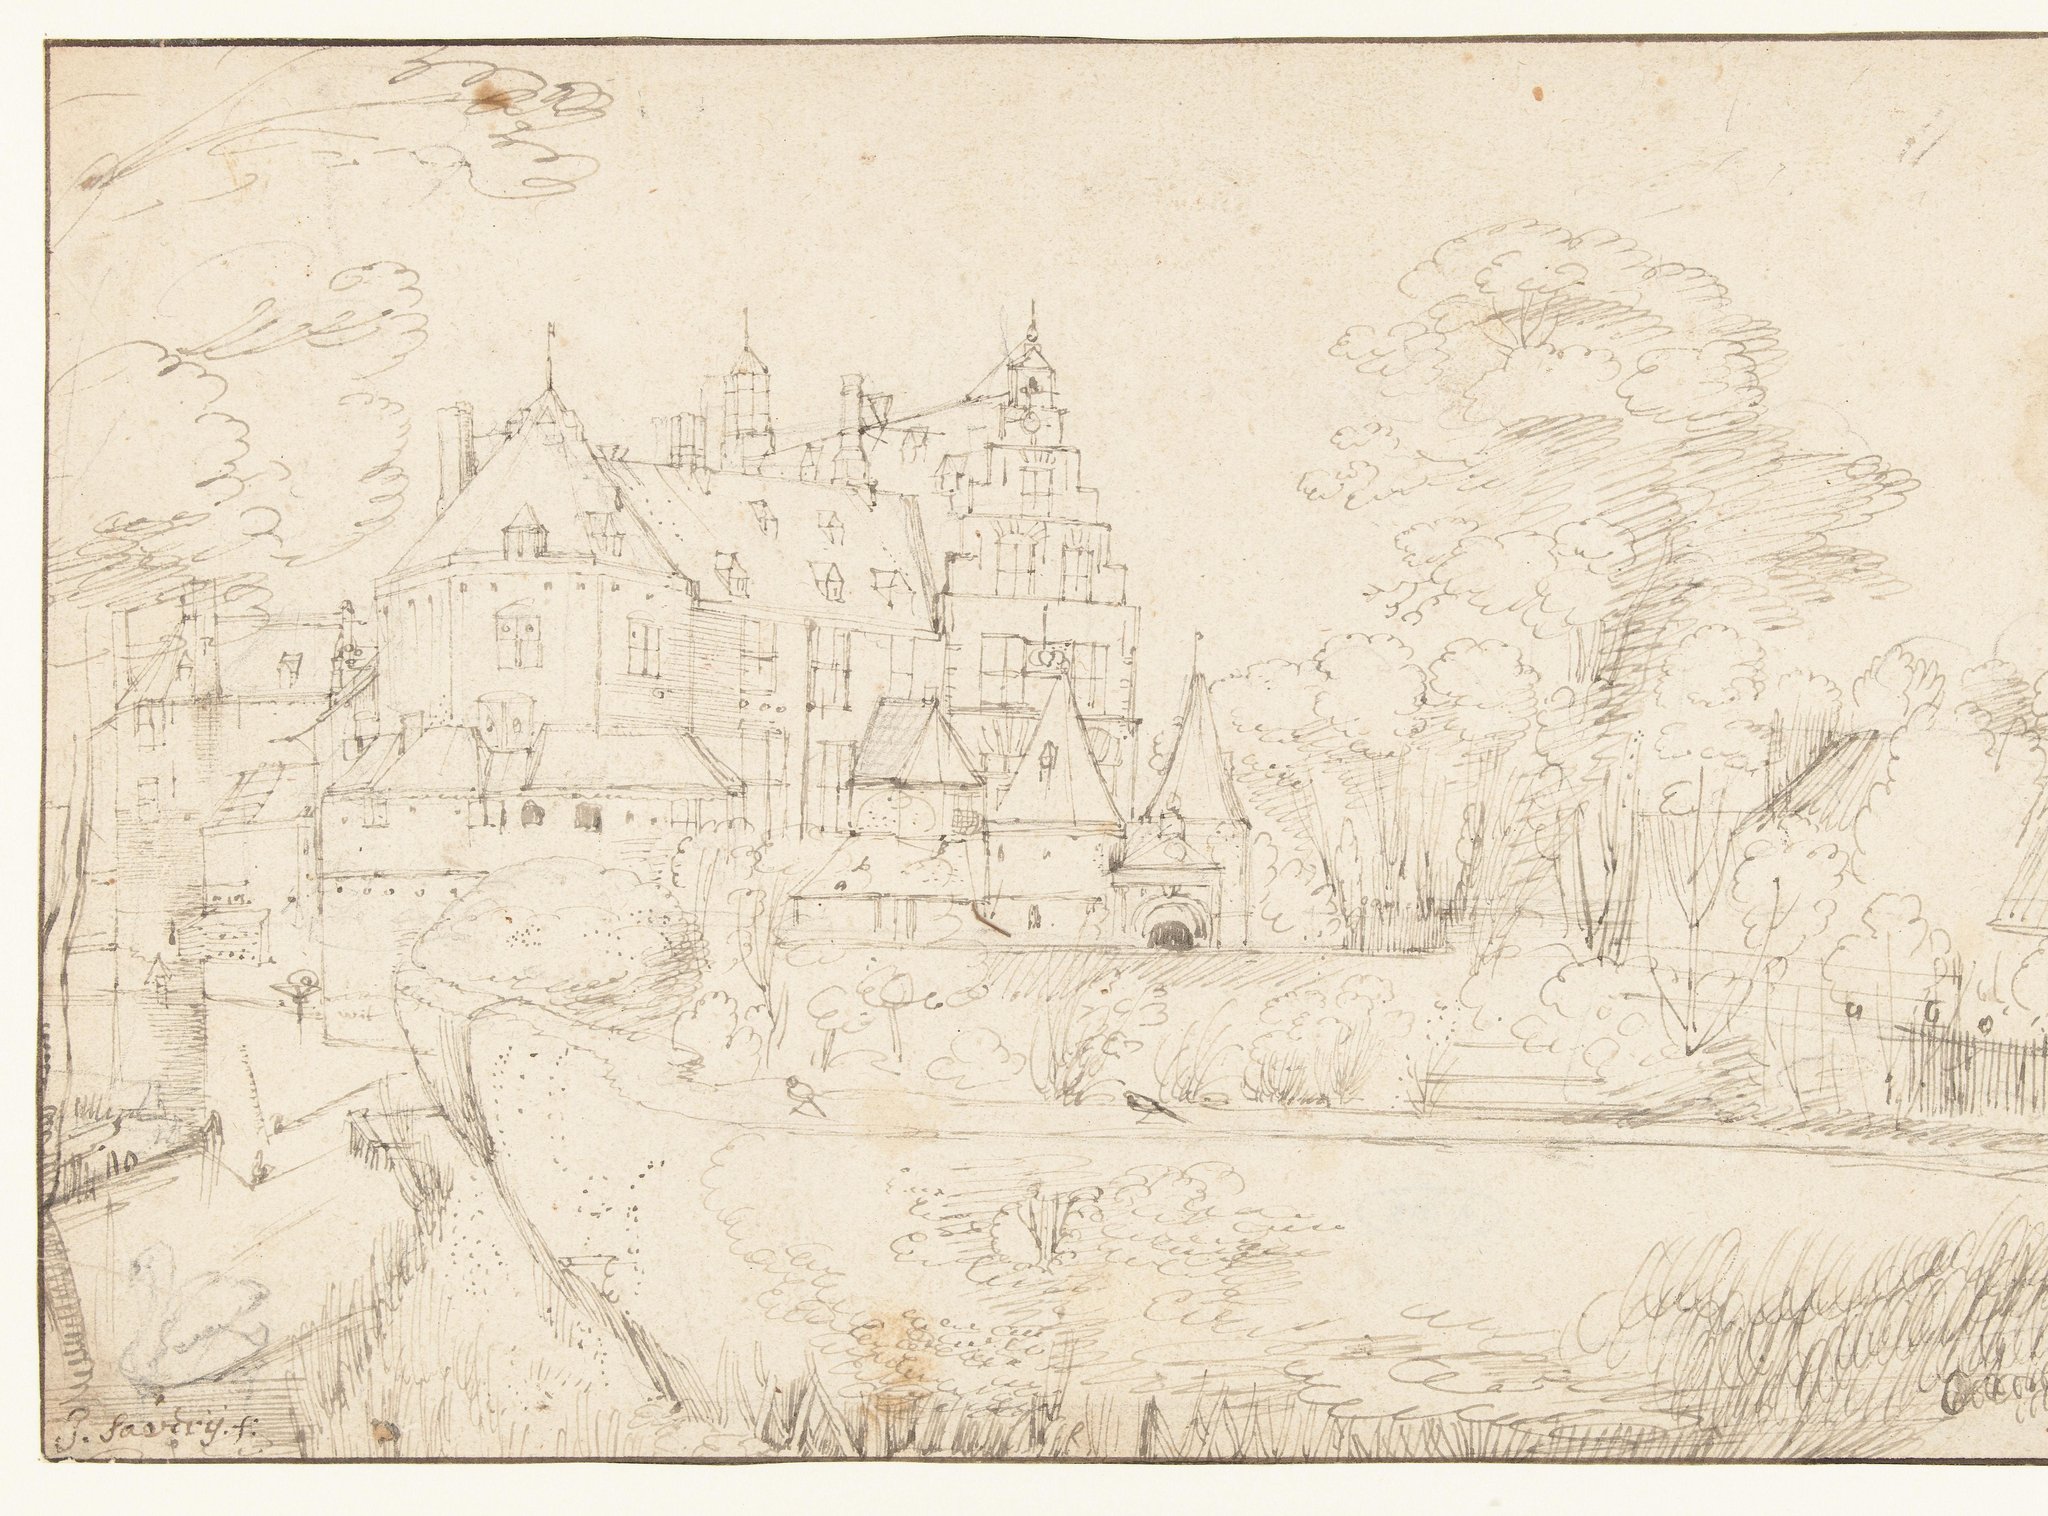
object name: drawing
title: Gezicht op een kasteel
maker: jacob savery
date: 1575-1666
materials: ink, paper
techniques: pen